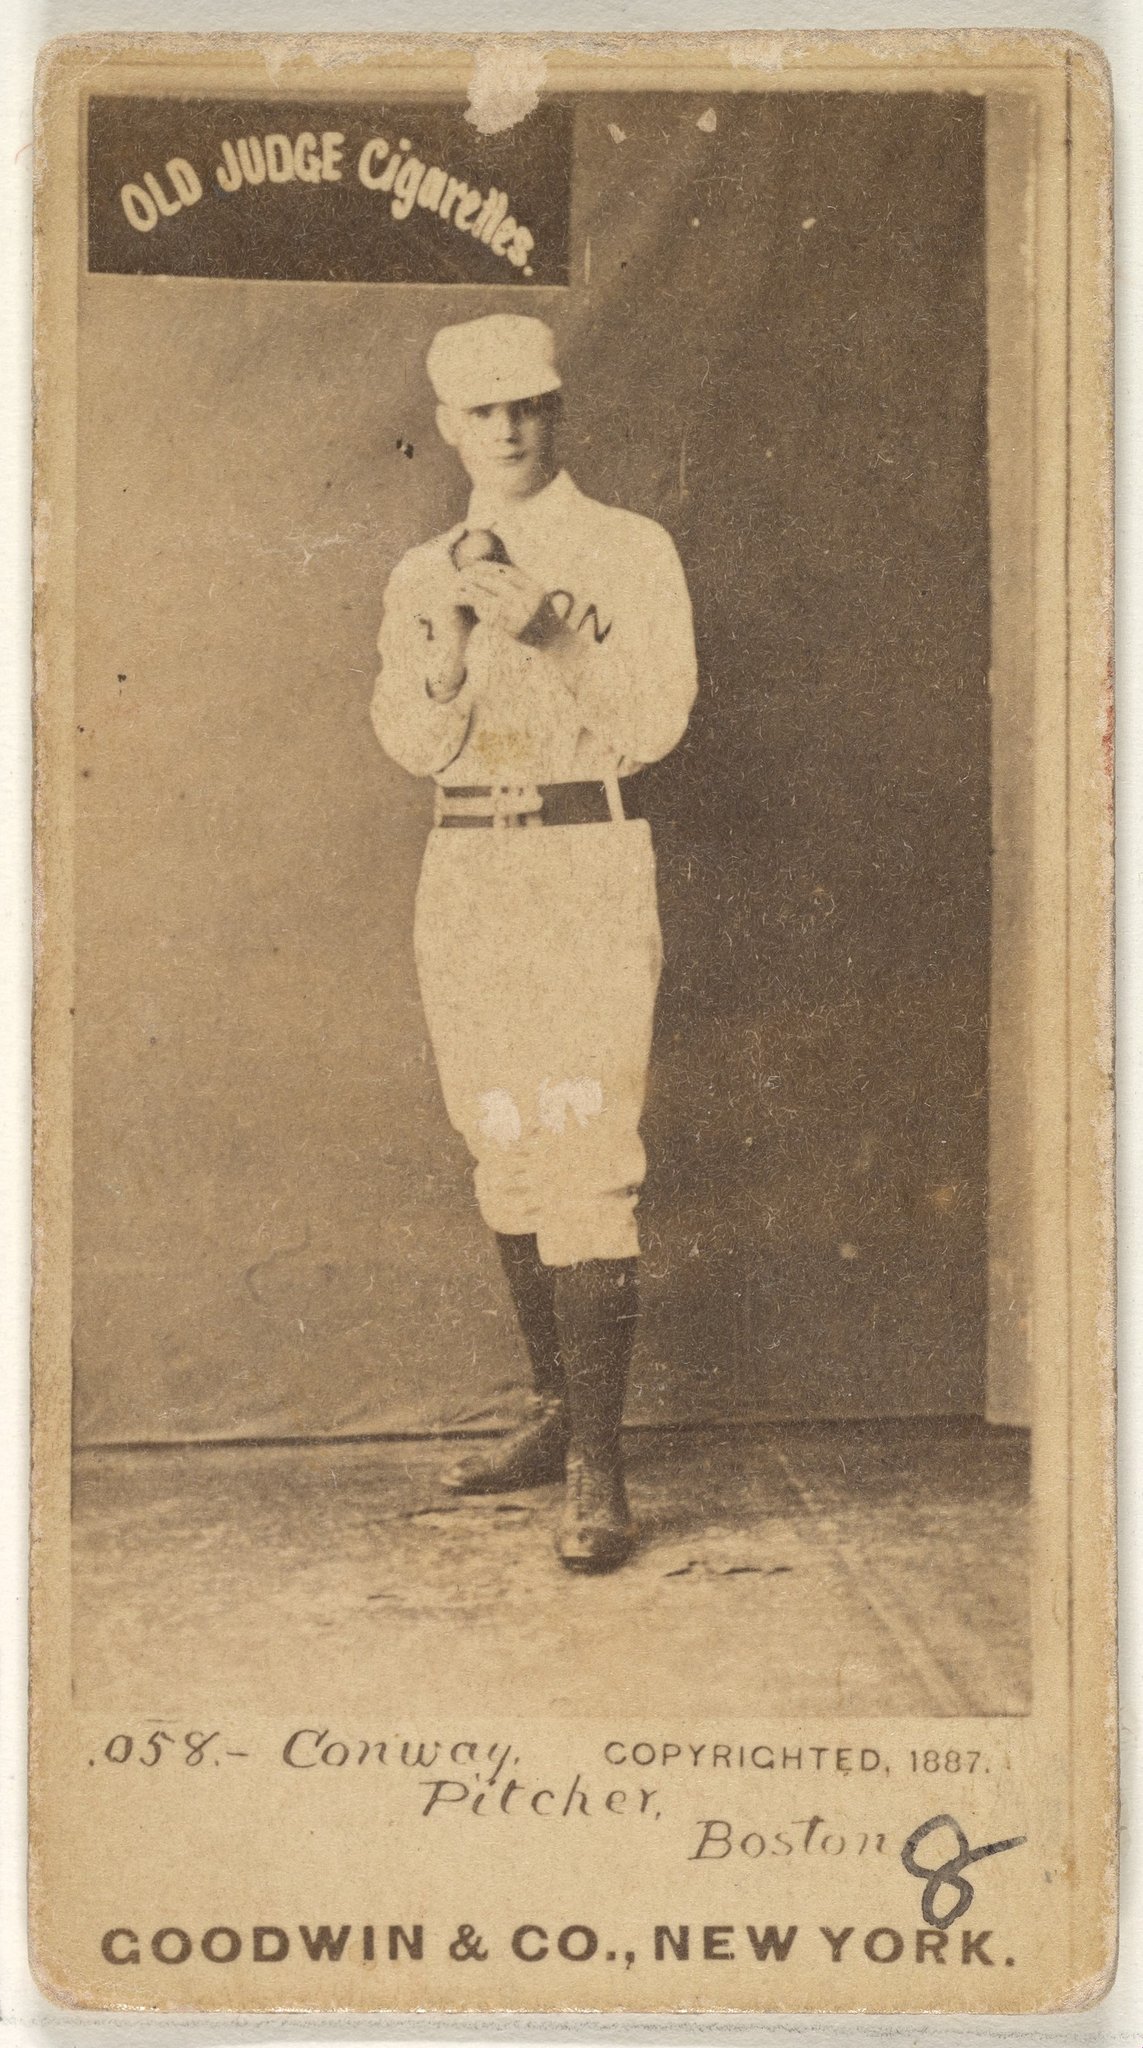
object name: baseball card, photograph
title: Conway, Pitcher, Boston, from the Old Judge series (N172) for Old Judge Cigarettes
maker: goodwin & company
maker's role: publisher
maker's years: 1850-1950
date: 1887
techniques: albumen silver print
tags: men,portraits,baseball,athletes